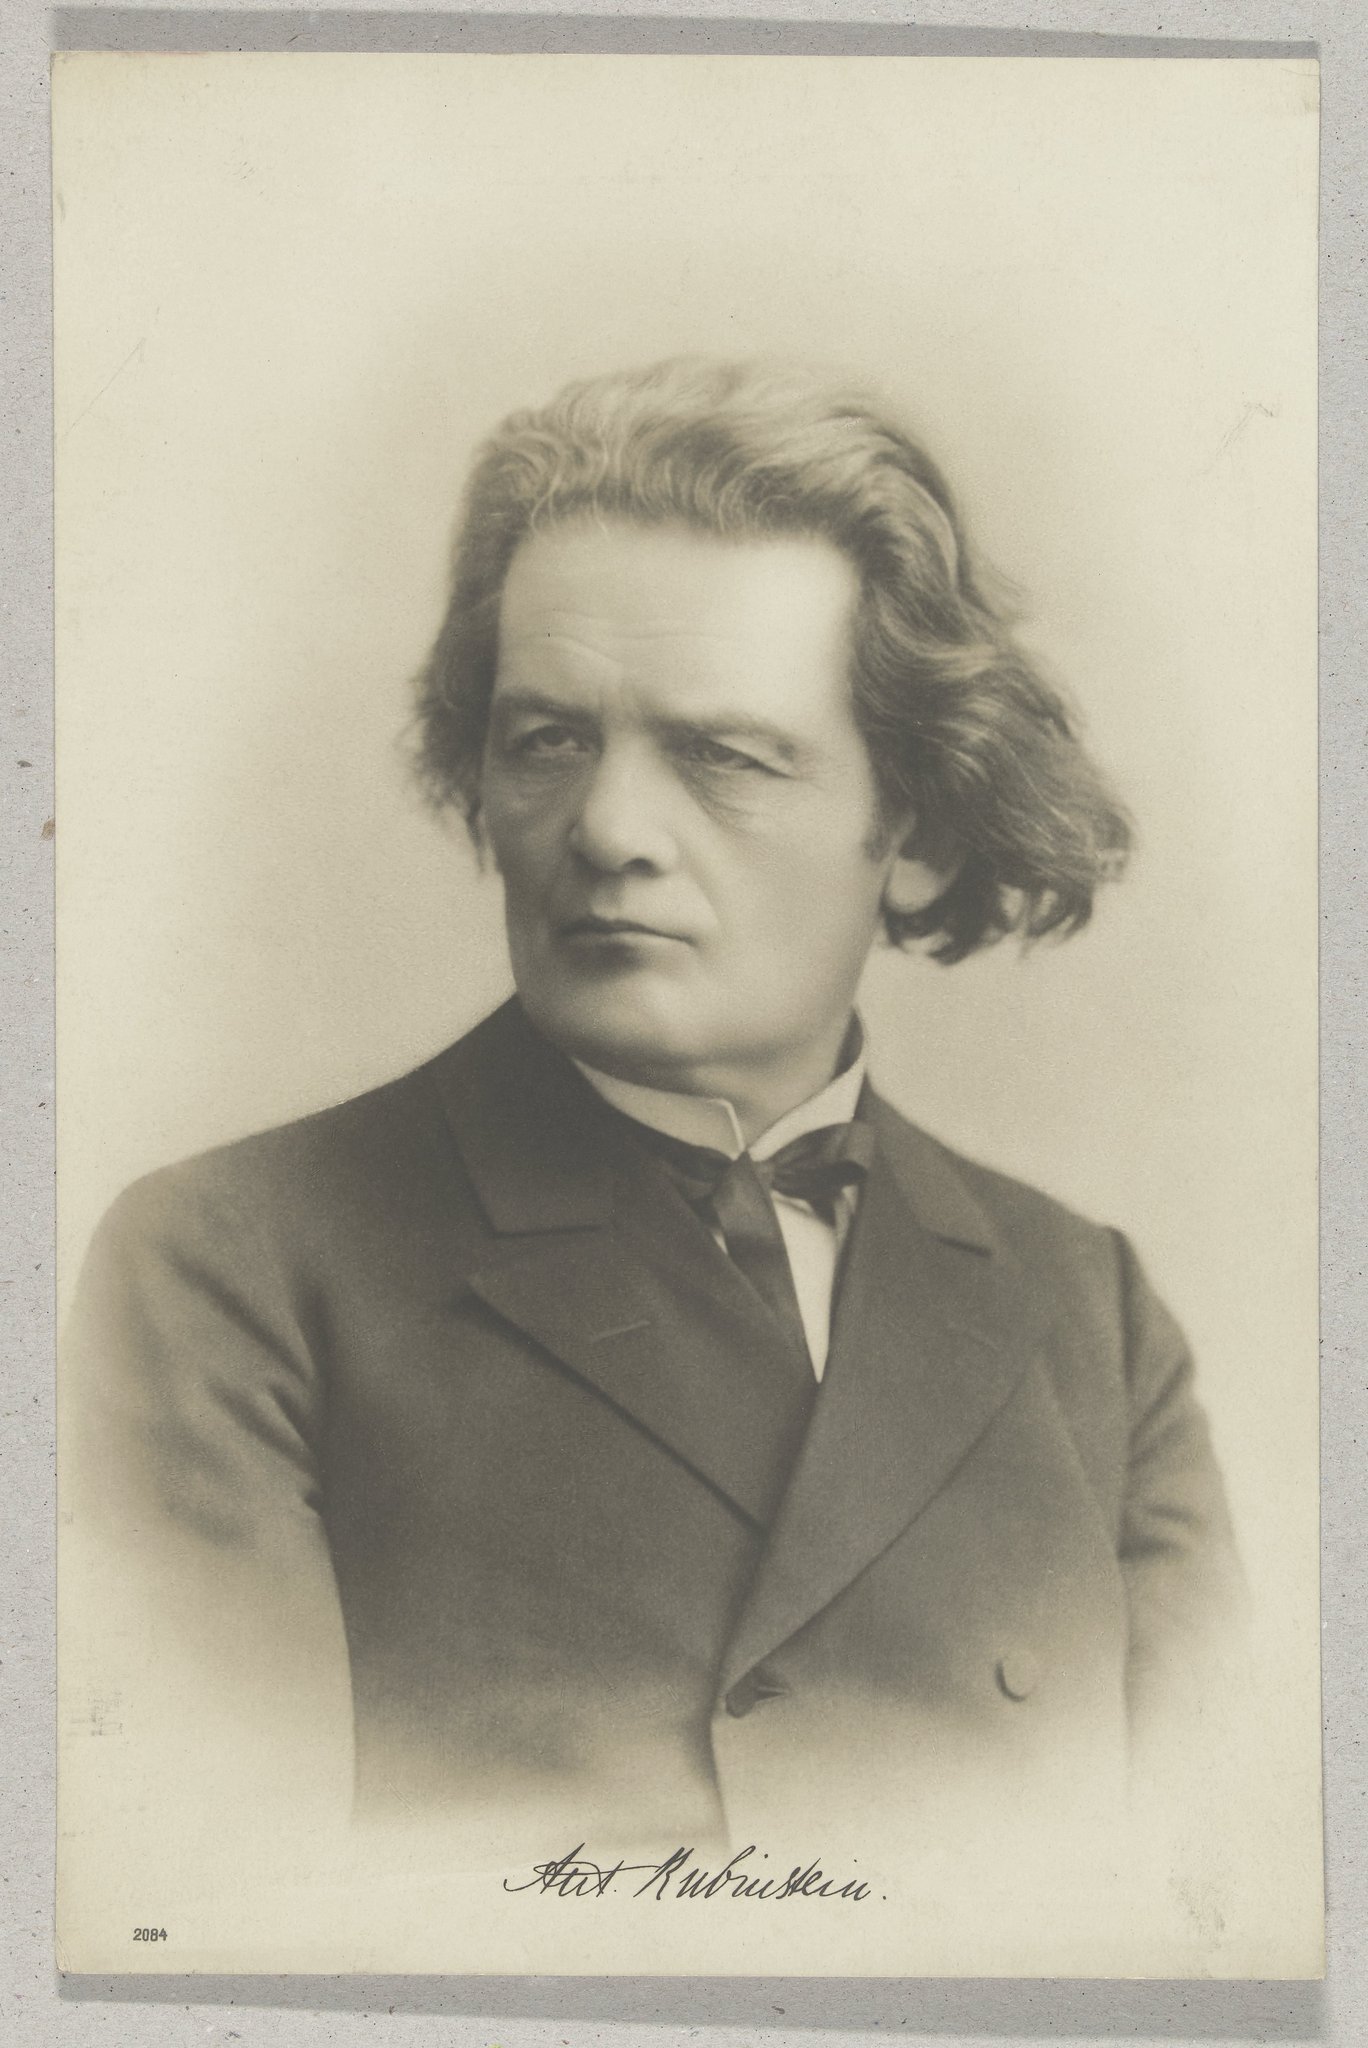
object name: photograph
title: Portret van componist, pianist en dirigent Anton Rubinstein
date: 1880-1920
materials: paper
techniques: matte daylight collodion silver print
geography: the hague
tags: historical persons, portrait of composer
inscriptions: name: ‘Rijshouwer's Establishment fromerly Parson. Photographs etc. 11 Lange Poten - the Hague. Holland’